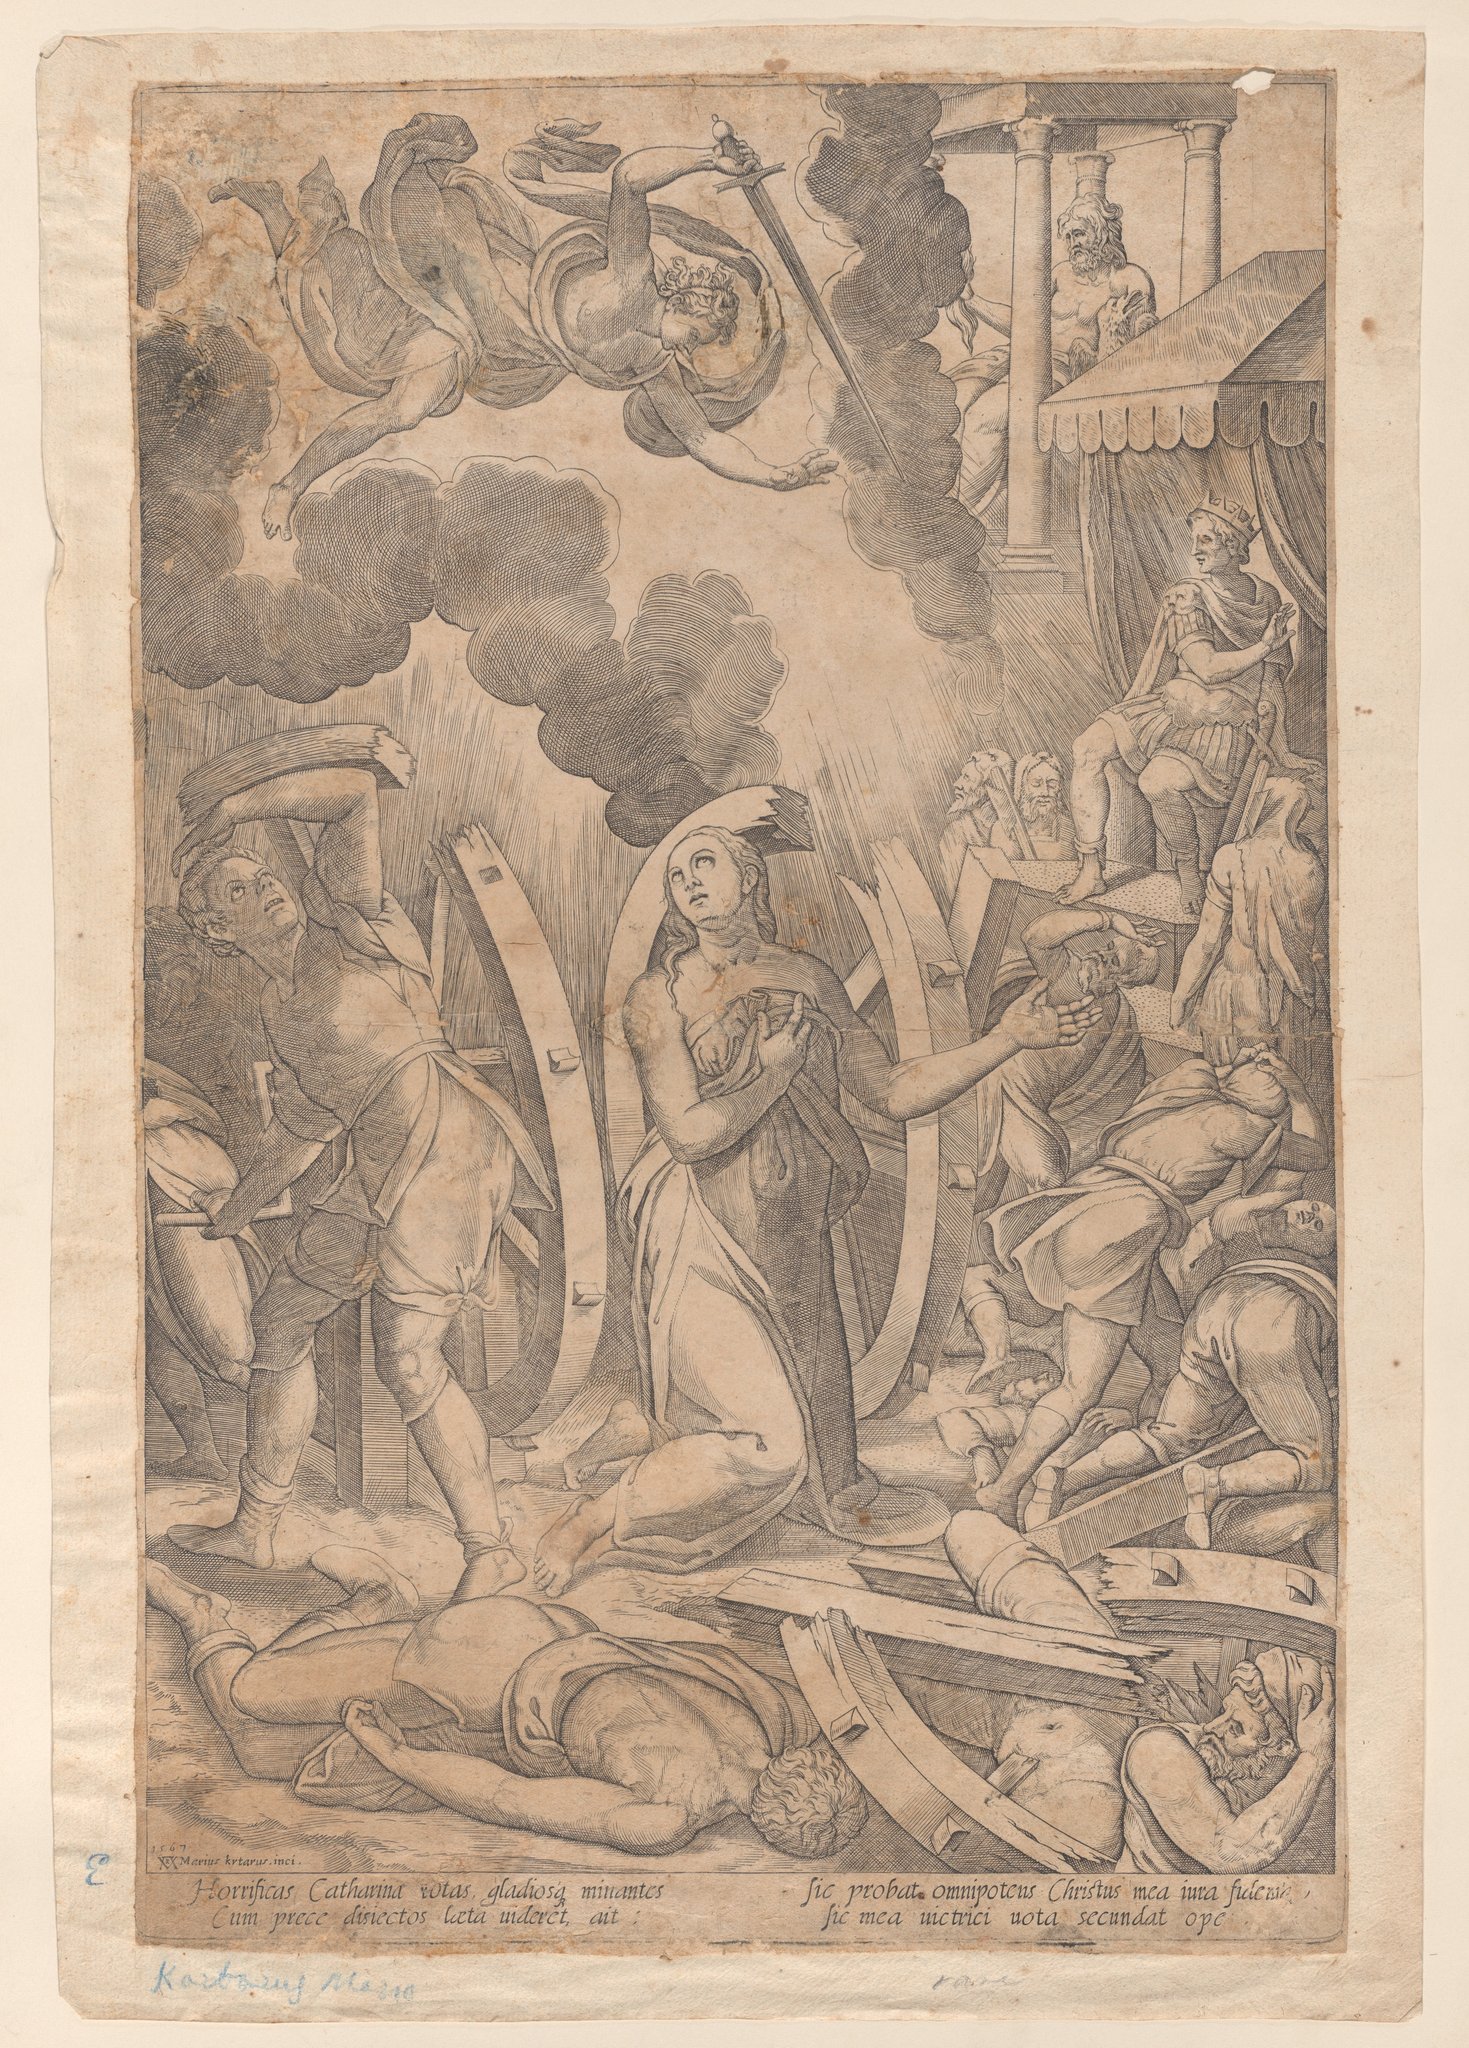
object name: print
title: Martyrdom of Saint Catherine of Alexandria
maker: mario cartaro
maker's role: artist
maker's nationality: italian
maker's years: 1557-1620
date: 1567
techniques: engraving